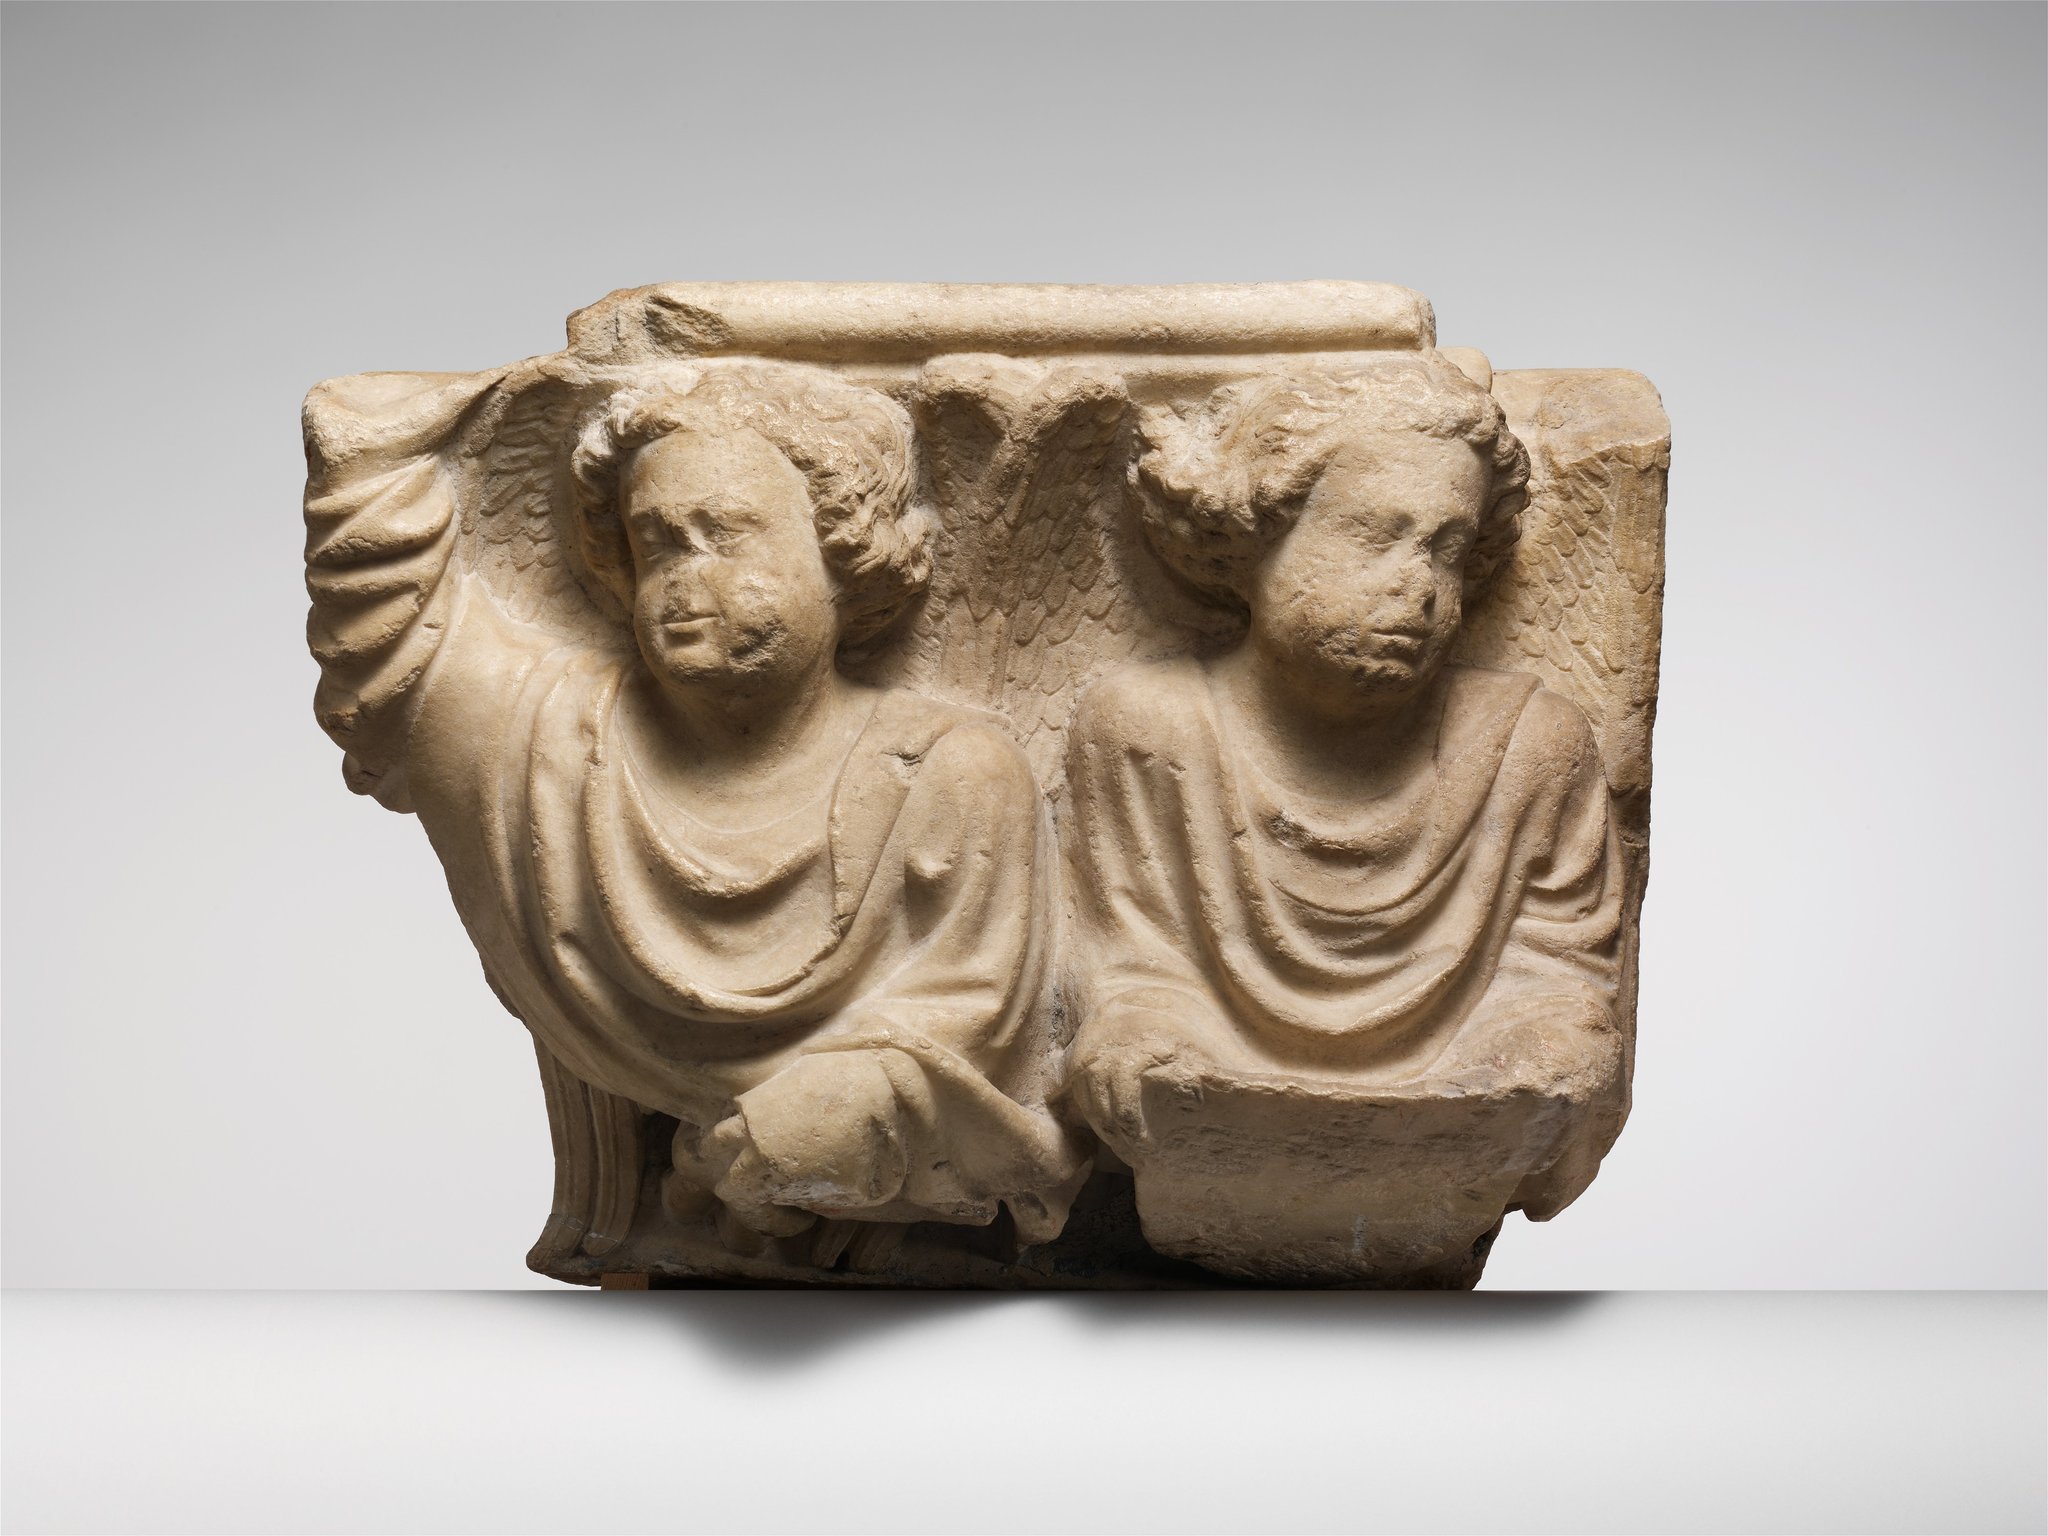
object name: corbel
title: Corbel with Busts of Angels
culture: italian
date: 1430-1440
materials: marble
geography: italy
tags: angels